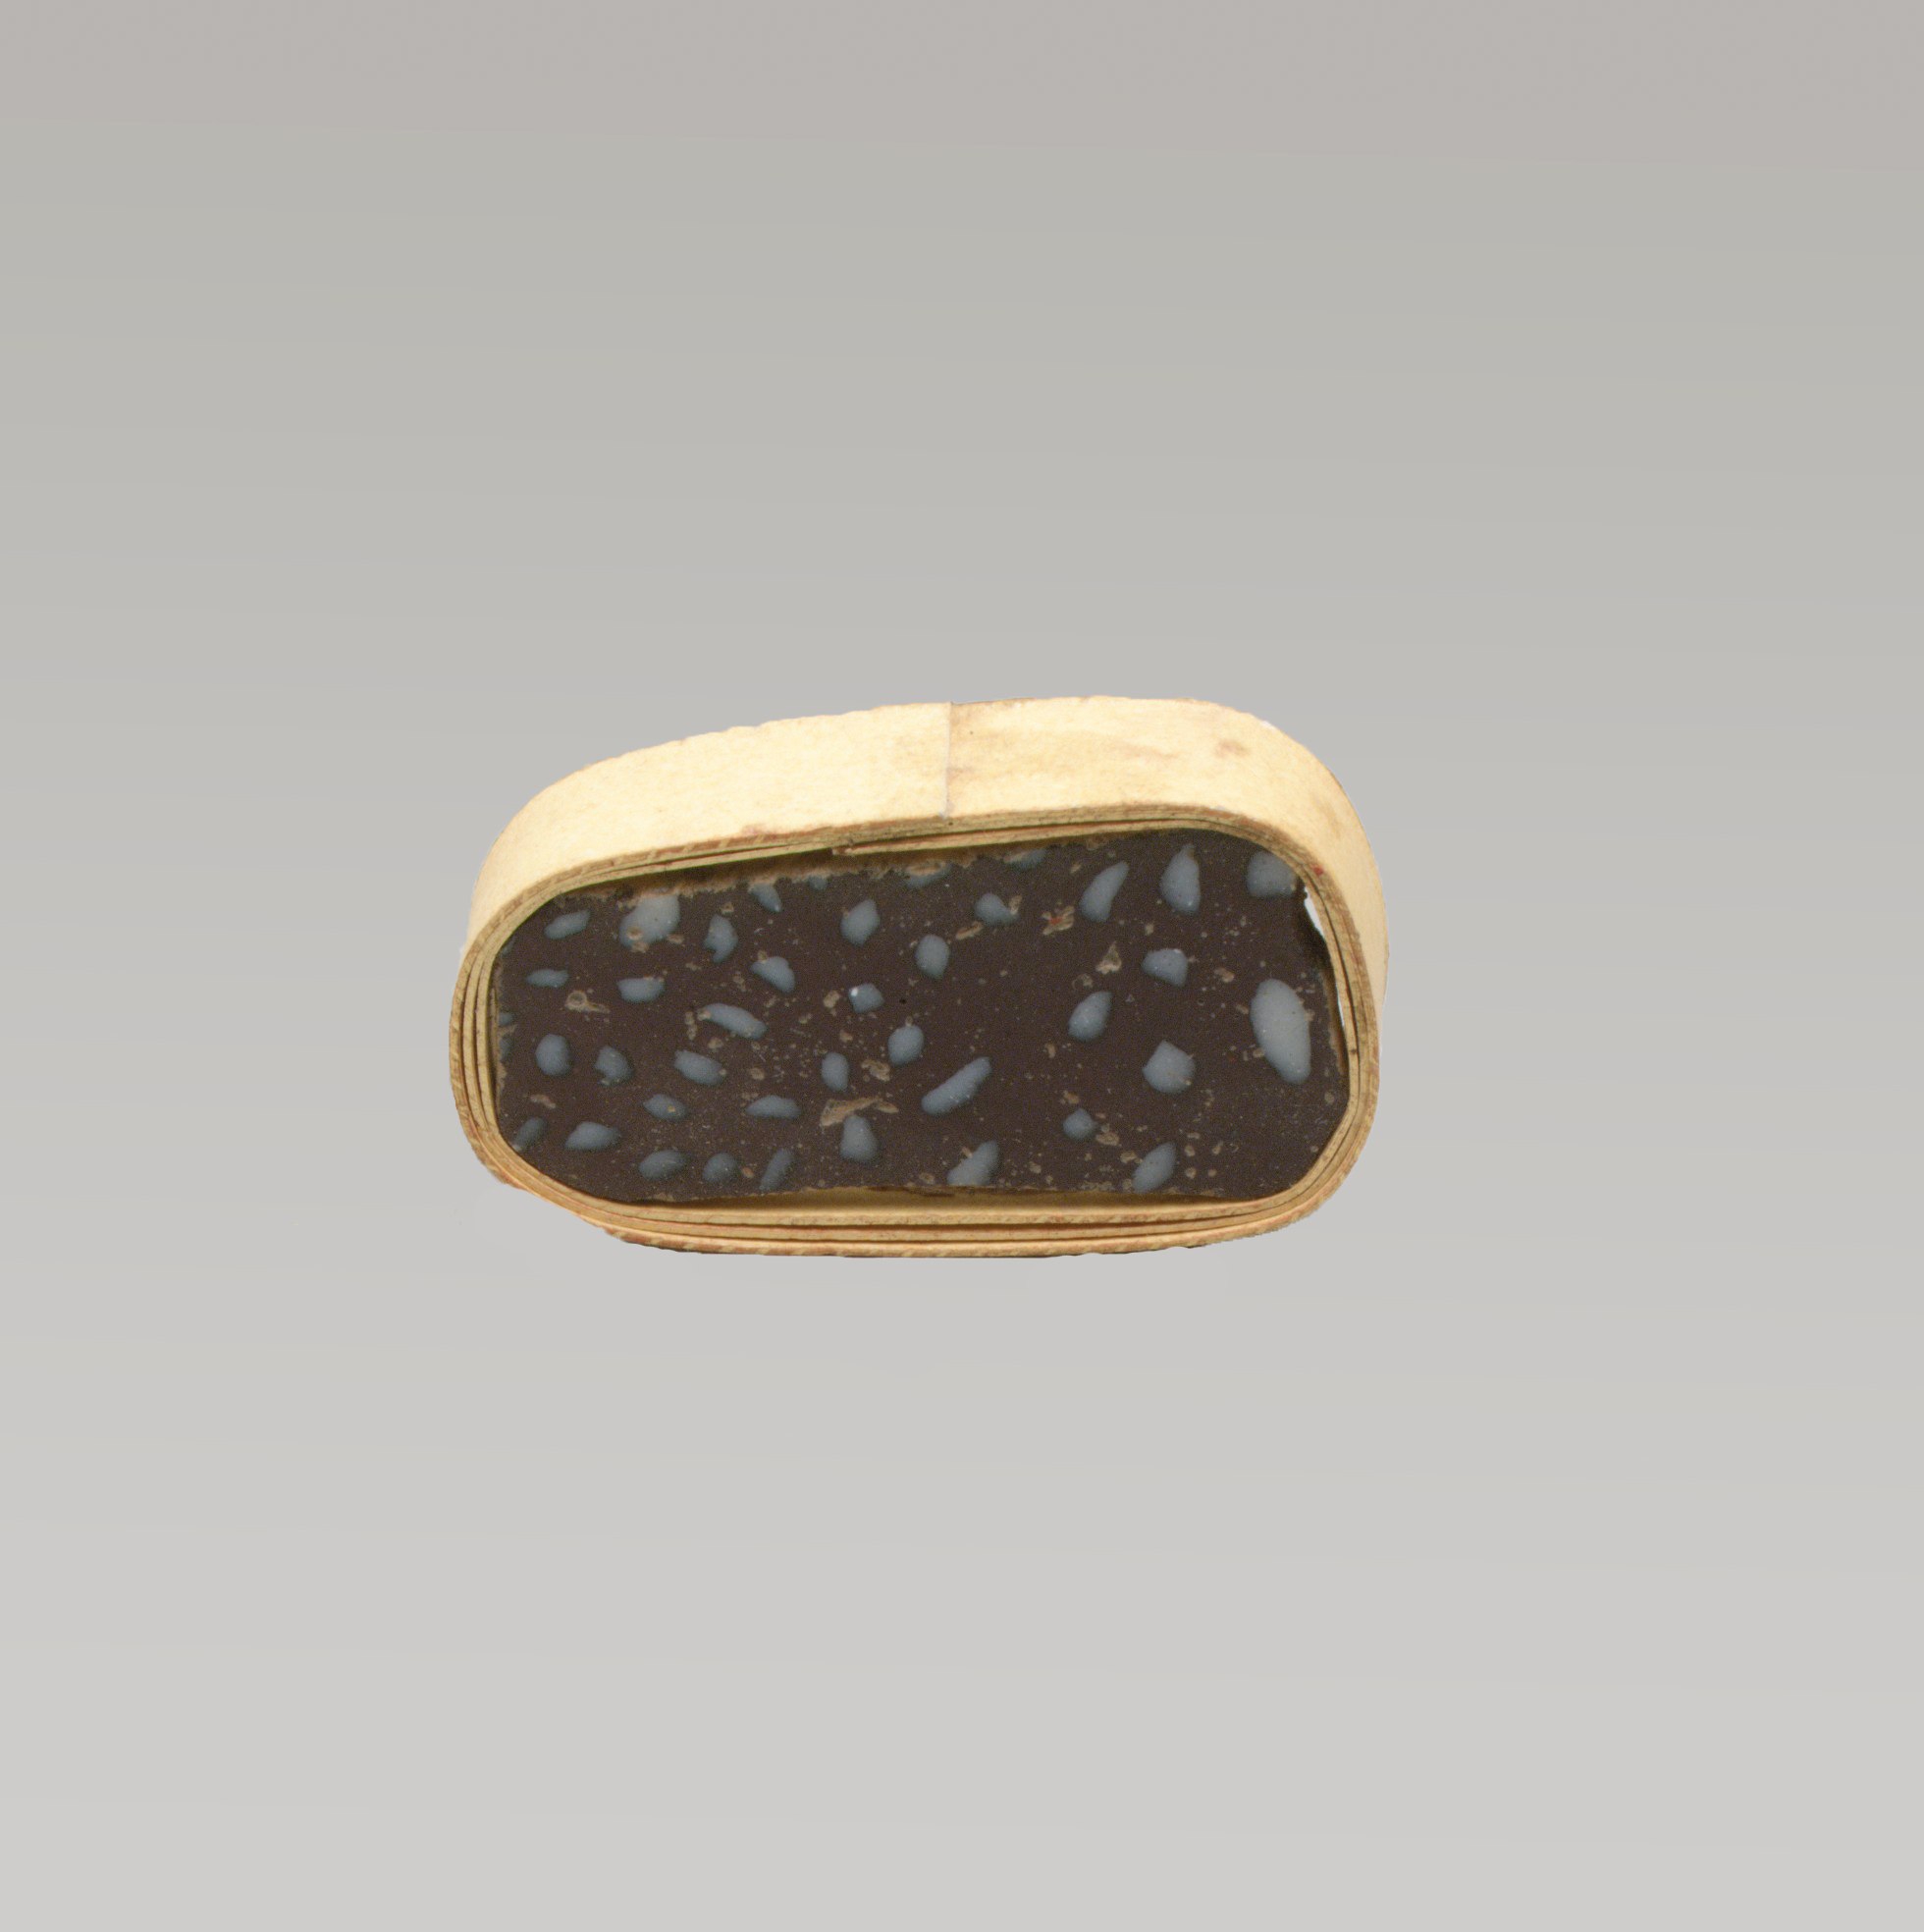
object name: fragment, mosaic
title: Glass mosaic inlay fragment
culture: roman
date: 34 BCE-33 CE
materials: glass